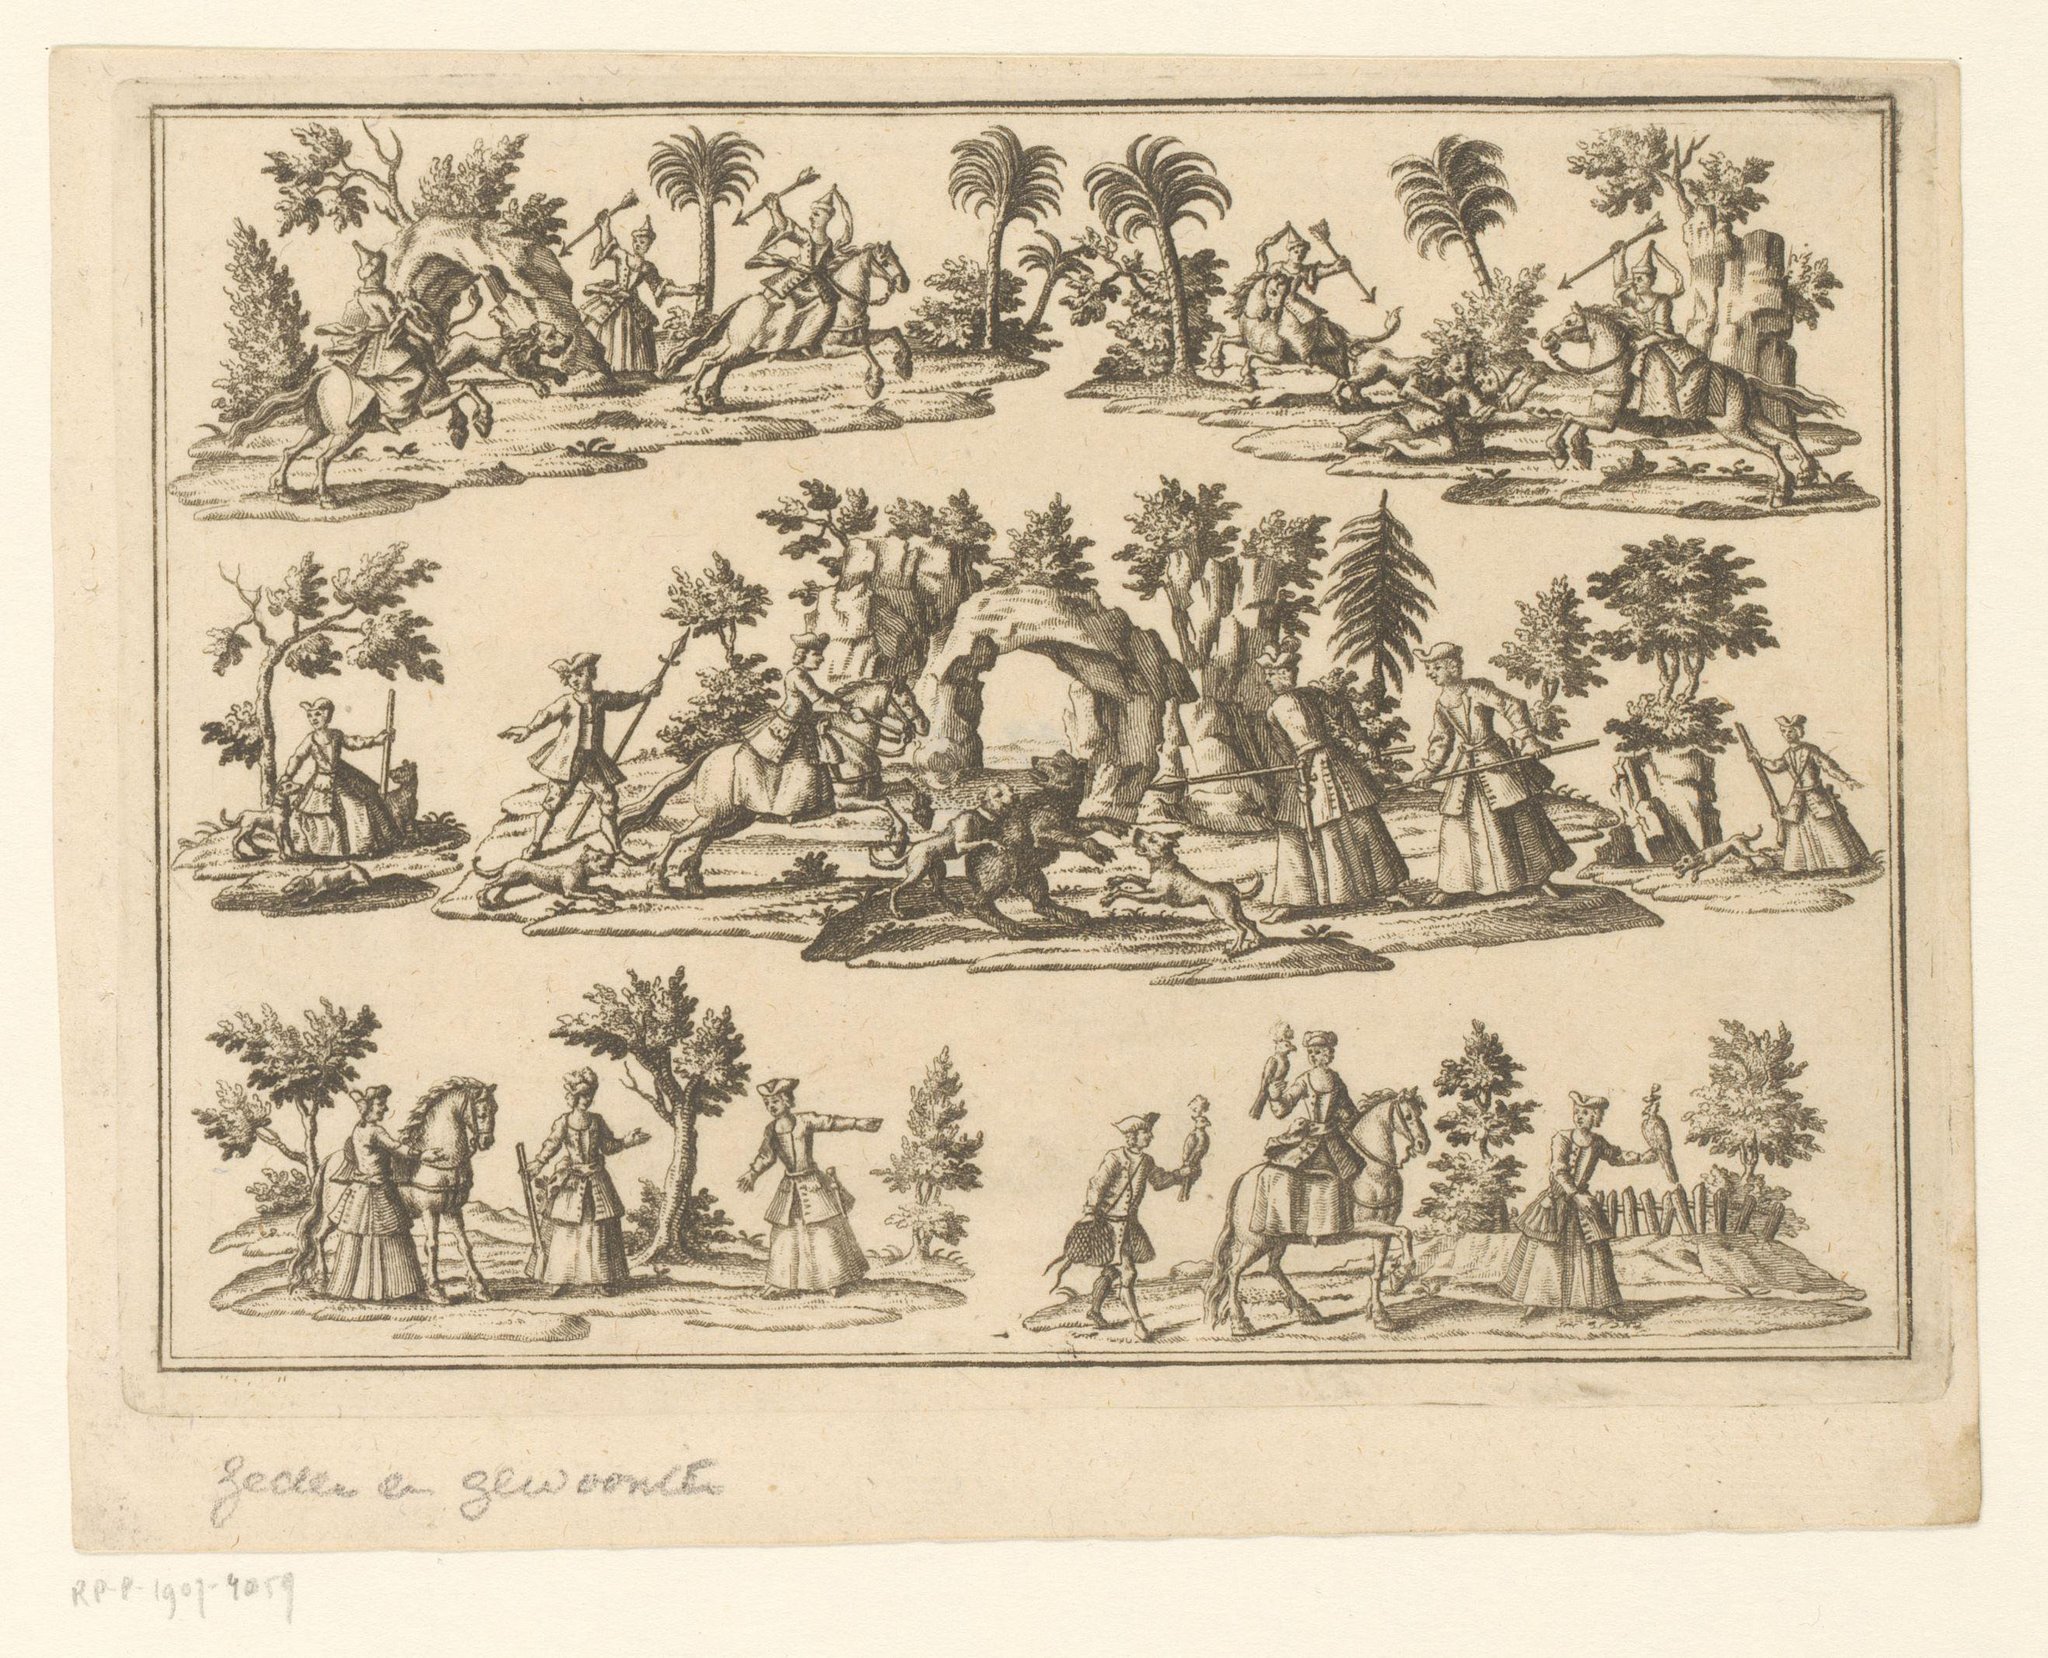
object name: print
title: Verscheyde Playsante Jagten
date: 1718-1757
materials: paper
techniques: etching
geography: amsterdam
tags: hunted animal attacking man, hunting dogs, casting weapons: spear, beasts of prey, predatory animals: bear, hunt ~ mammals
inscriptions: collector's mark: Lugt 2228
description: Op de prent staan zeven landschappen met jachtvoorstellingen. Centraal een voorstelling van twee honden die een beer aanvallen. Om de beer heen vier jagers met speren.